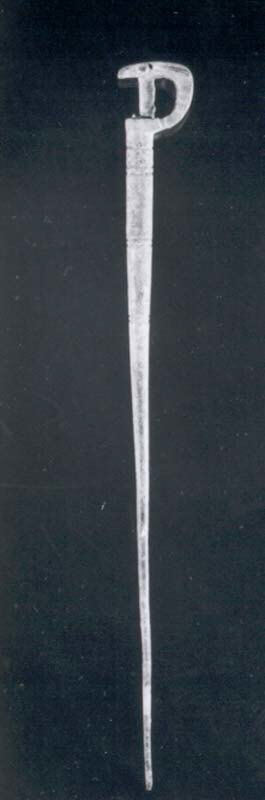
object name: pin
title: Zoomorphic pin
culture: iranian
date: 1000-1 BCE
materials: bronze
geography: iran